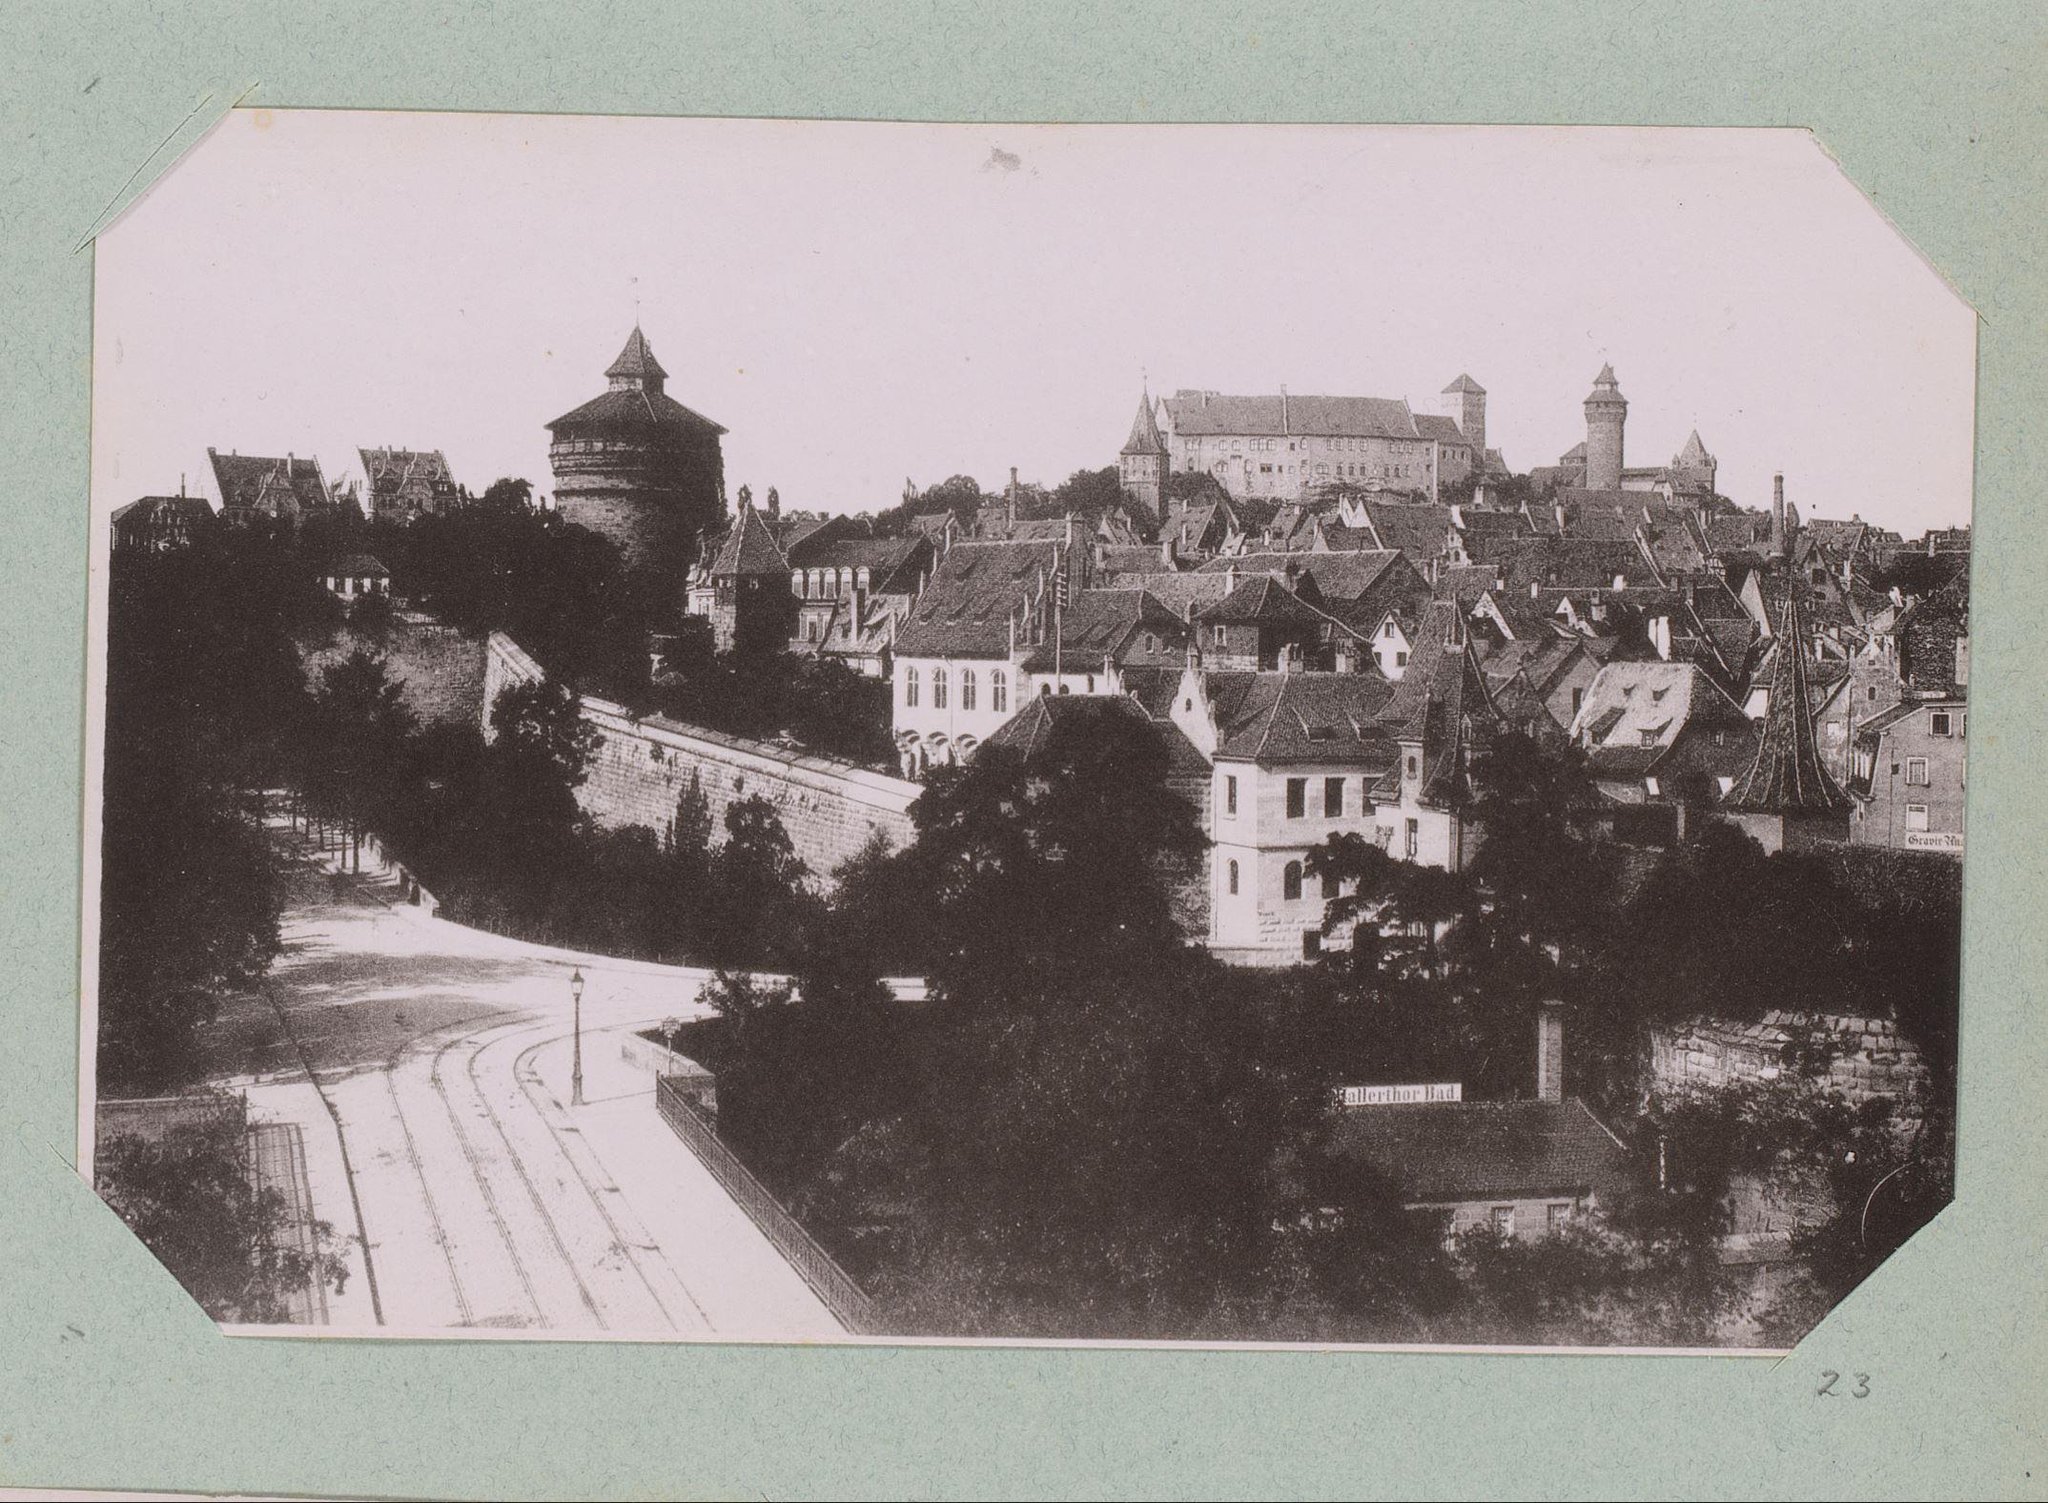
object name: album leaf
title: Gezicht op Neurenberg, met de Neutorturm en de burcht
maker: Anonymous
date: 1890-1900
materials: paper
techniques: photograph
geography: nuremberg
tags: city-view in general; 'veduta', towers ~ fortified city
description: Deze prent maakt deel uit van een album.